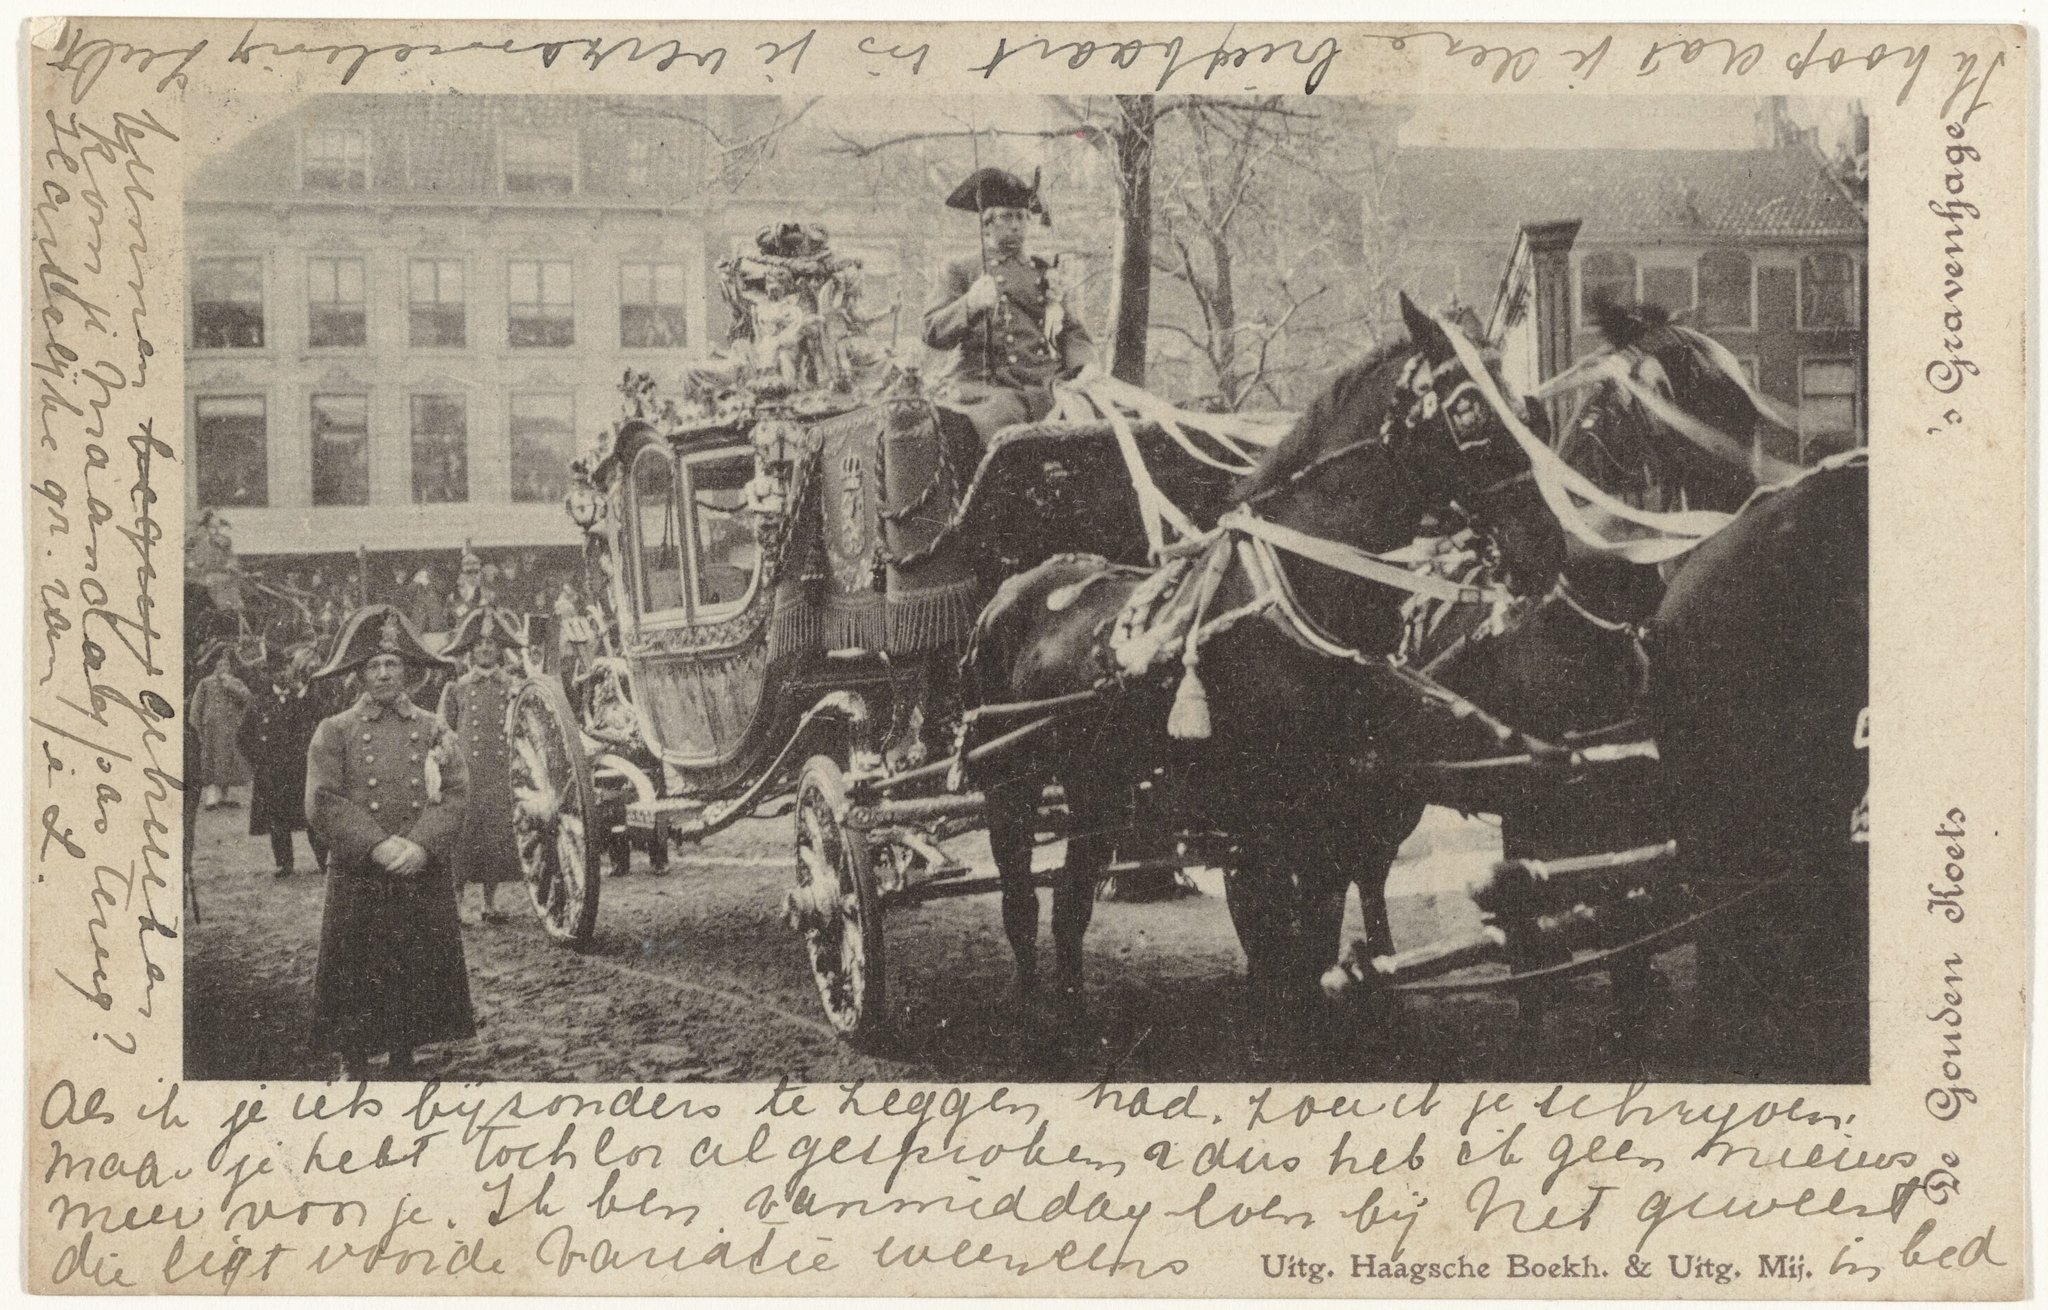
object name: photomechanical print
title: De gouden koets van de huwelijksstoet van Wilhelmina, koningin der Nederlanden, en Hendrik van Mecklenburg-Schwerin te Den Haag op 7 februari 1901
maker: Anonymous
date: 1901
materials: paper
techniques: photograph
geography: netherlands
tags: the hague, print maker, wilhelmina of the netherlands, hendrik (prins der nederlanden (1876-1934)), animal traction, animal-drawn vehicle (carriage etc.), (civil) marriage ceremonies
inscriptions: inscription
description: De hier vermelde titel verwijst naar de hoogst verkregen titel van de geportretteerde, niet per se naar de titel die de geportretteerde op deze voorstelling draagt.